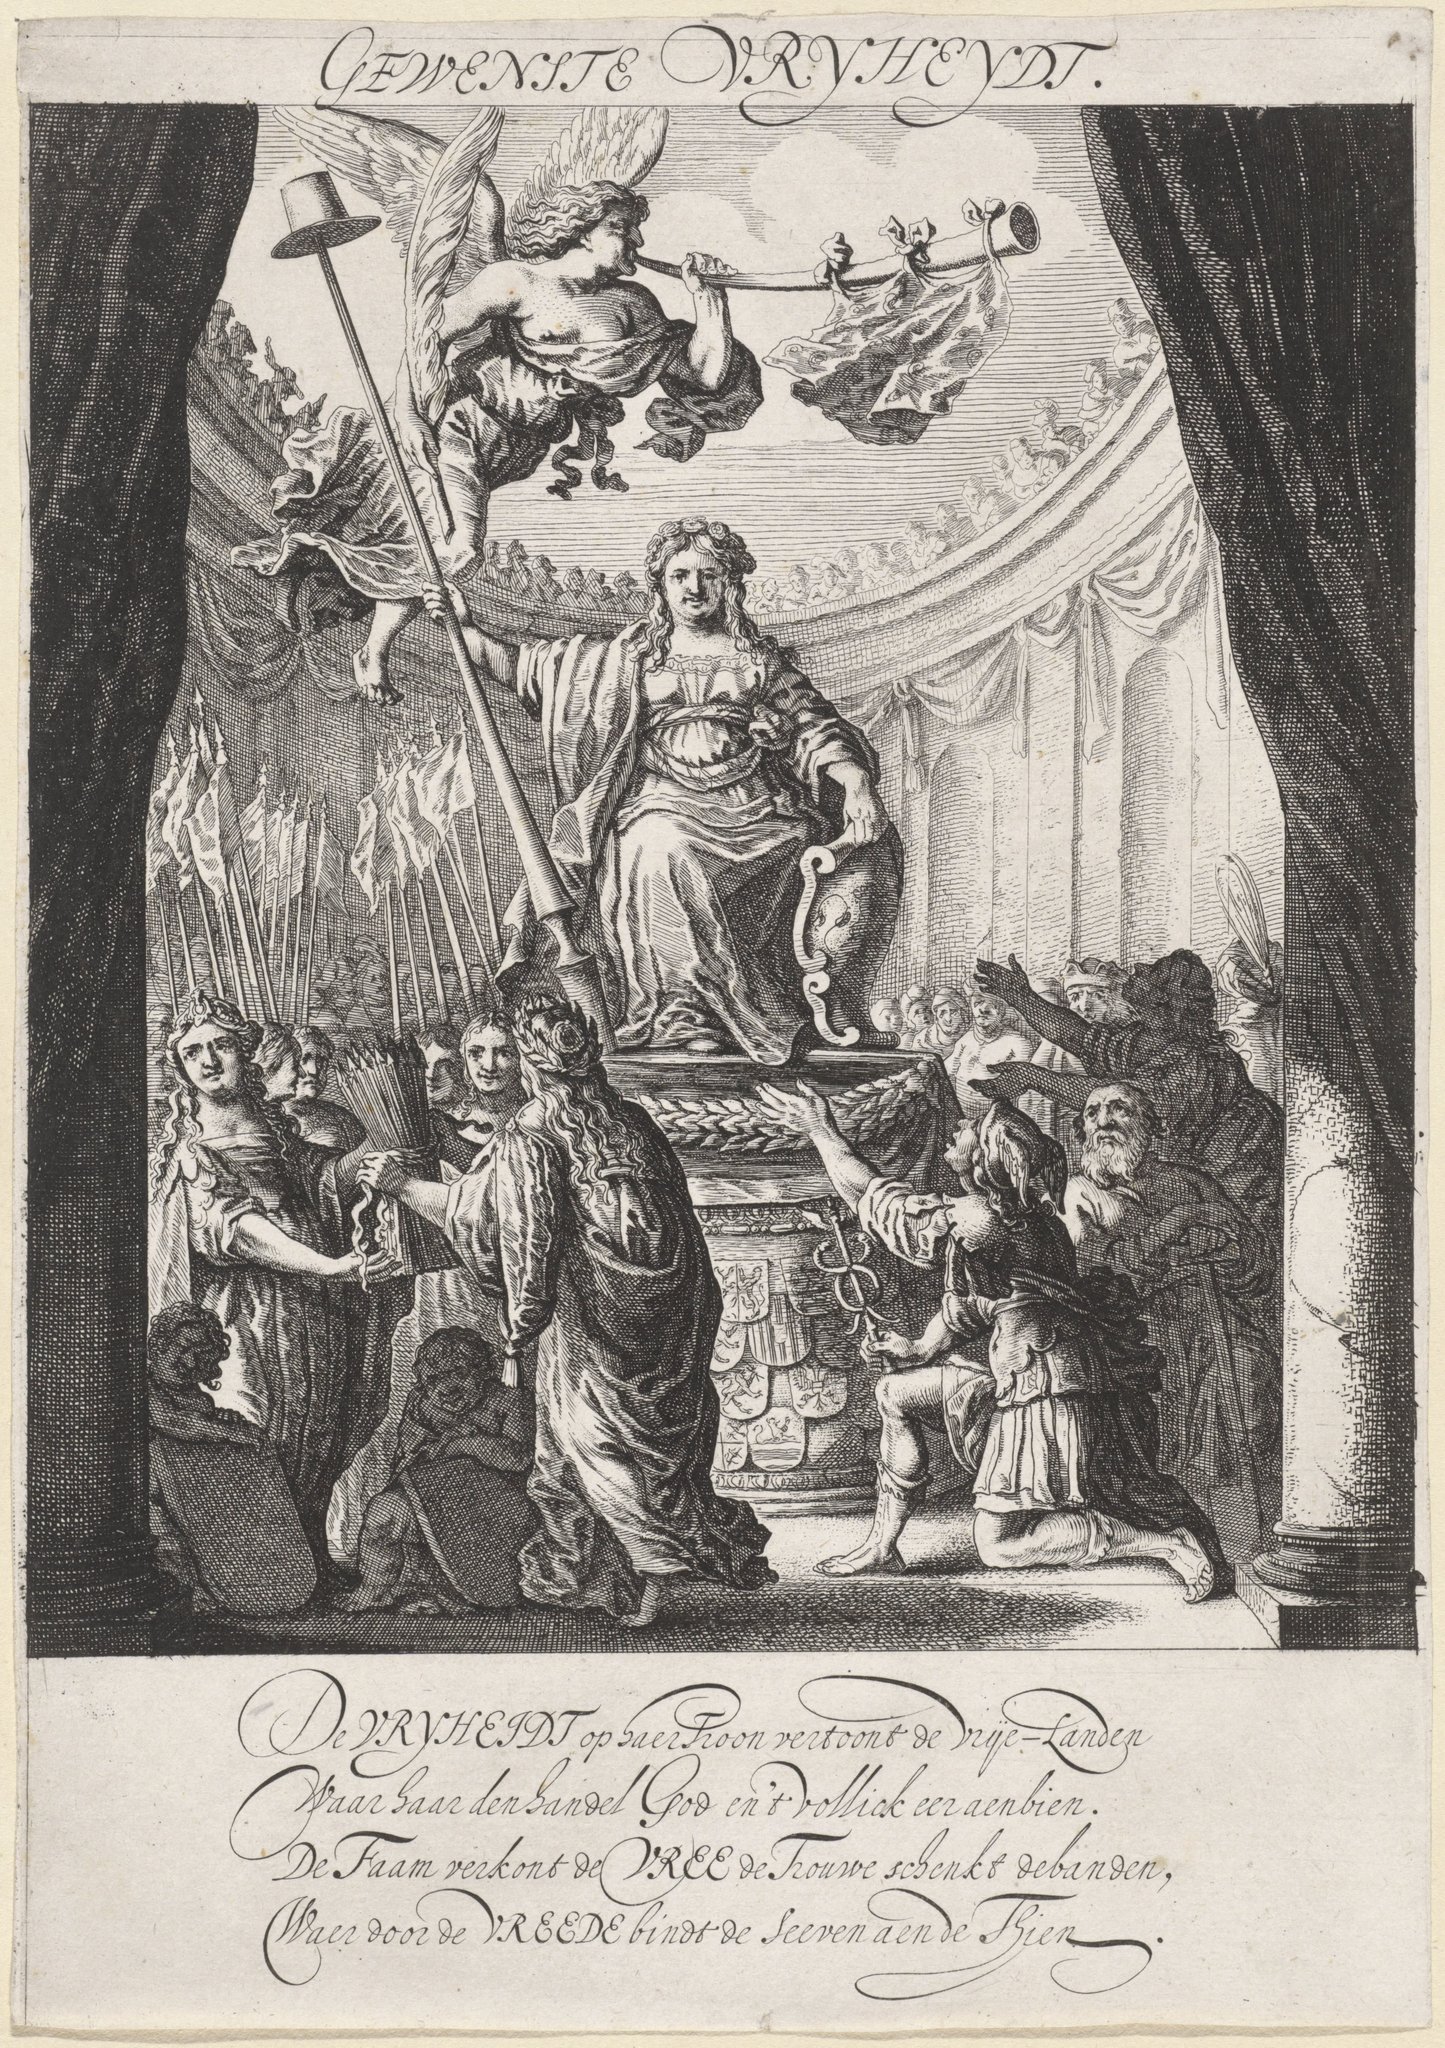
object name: print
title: Vertoning van de Gewenste Vrijheid, 1648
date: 1649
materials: paper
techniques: etching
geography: amsterdam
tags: theatre, theatrical performance, festivities on events of national importance, fame; 'fama', 'fama buona', 'fama chiara' (ripa), freedom, liberty; 'libertà' (ripa)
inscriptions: collector's mark: Lugt 240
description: Vertoning van de Gewenste Vrijheid. Onderdeel van de vertoningen opgevoerd op 23 juni 1648 op de Schouwburg te Amsterdam naar aanleiding van het sluiten van de Vrede van Munster. De tweede voorstelling toont de personificatie van de Vrijheid zittend op een voetstuk, in de lucht de Faam. In het onderschrift een vers van 4 regels in het Nederlands.